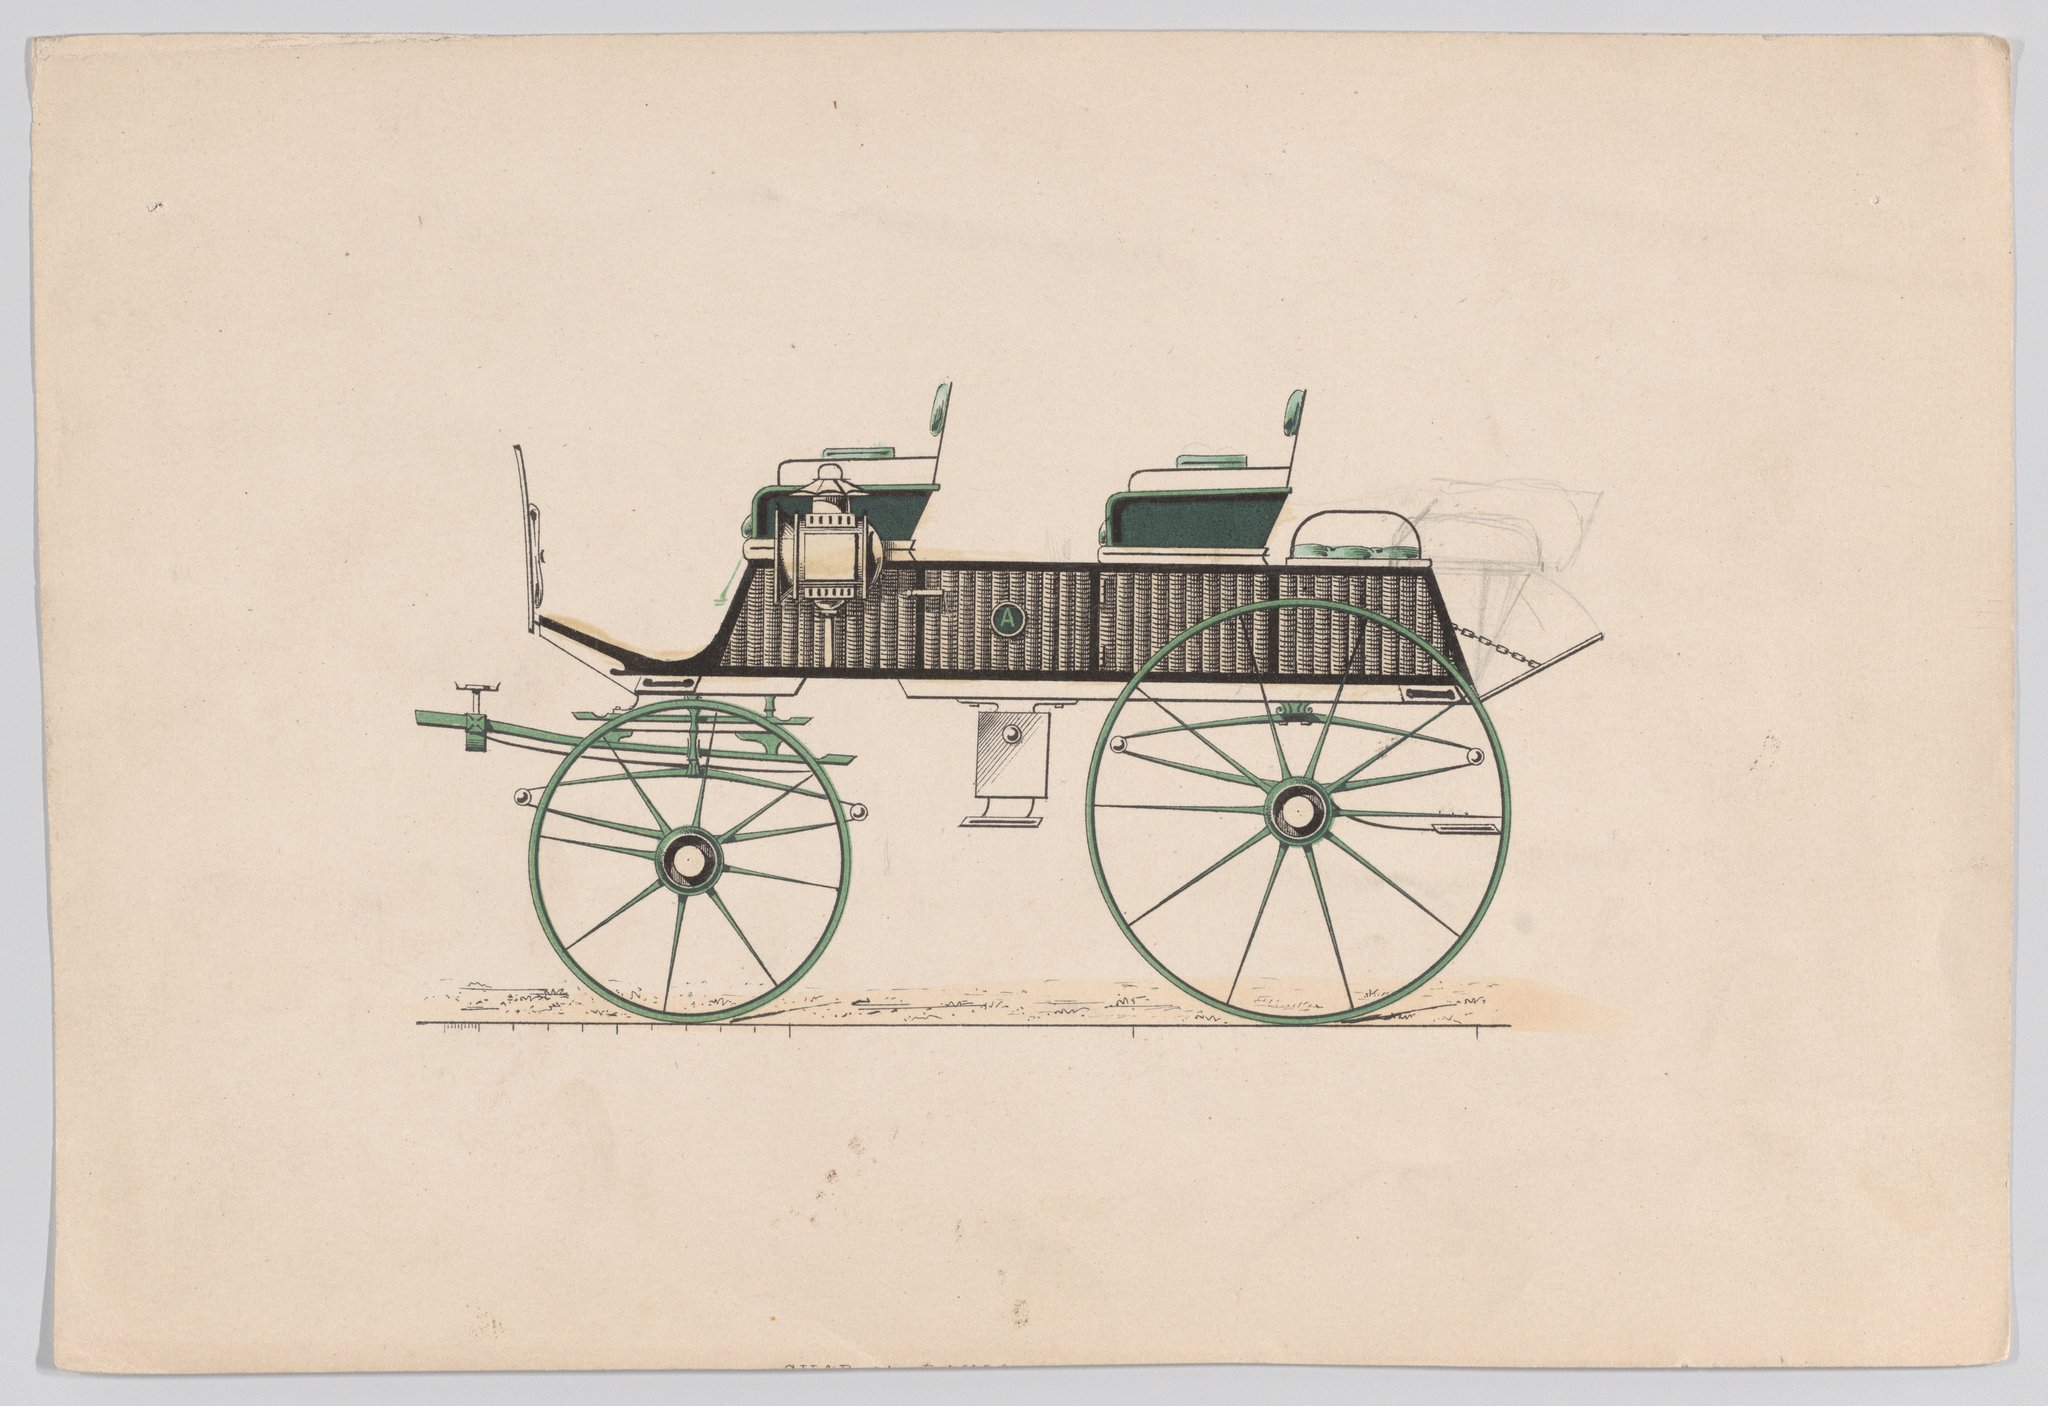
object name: print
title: Design for Phaeton or Hunting Wagon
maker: anonymous, french, 19th century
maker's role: artist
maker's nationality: french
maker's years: 1800-1900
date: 1870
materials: gum arabic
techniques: hand coloring, lithograph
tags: carriages